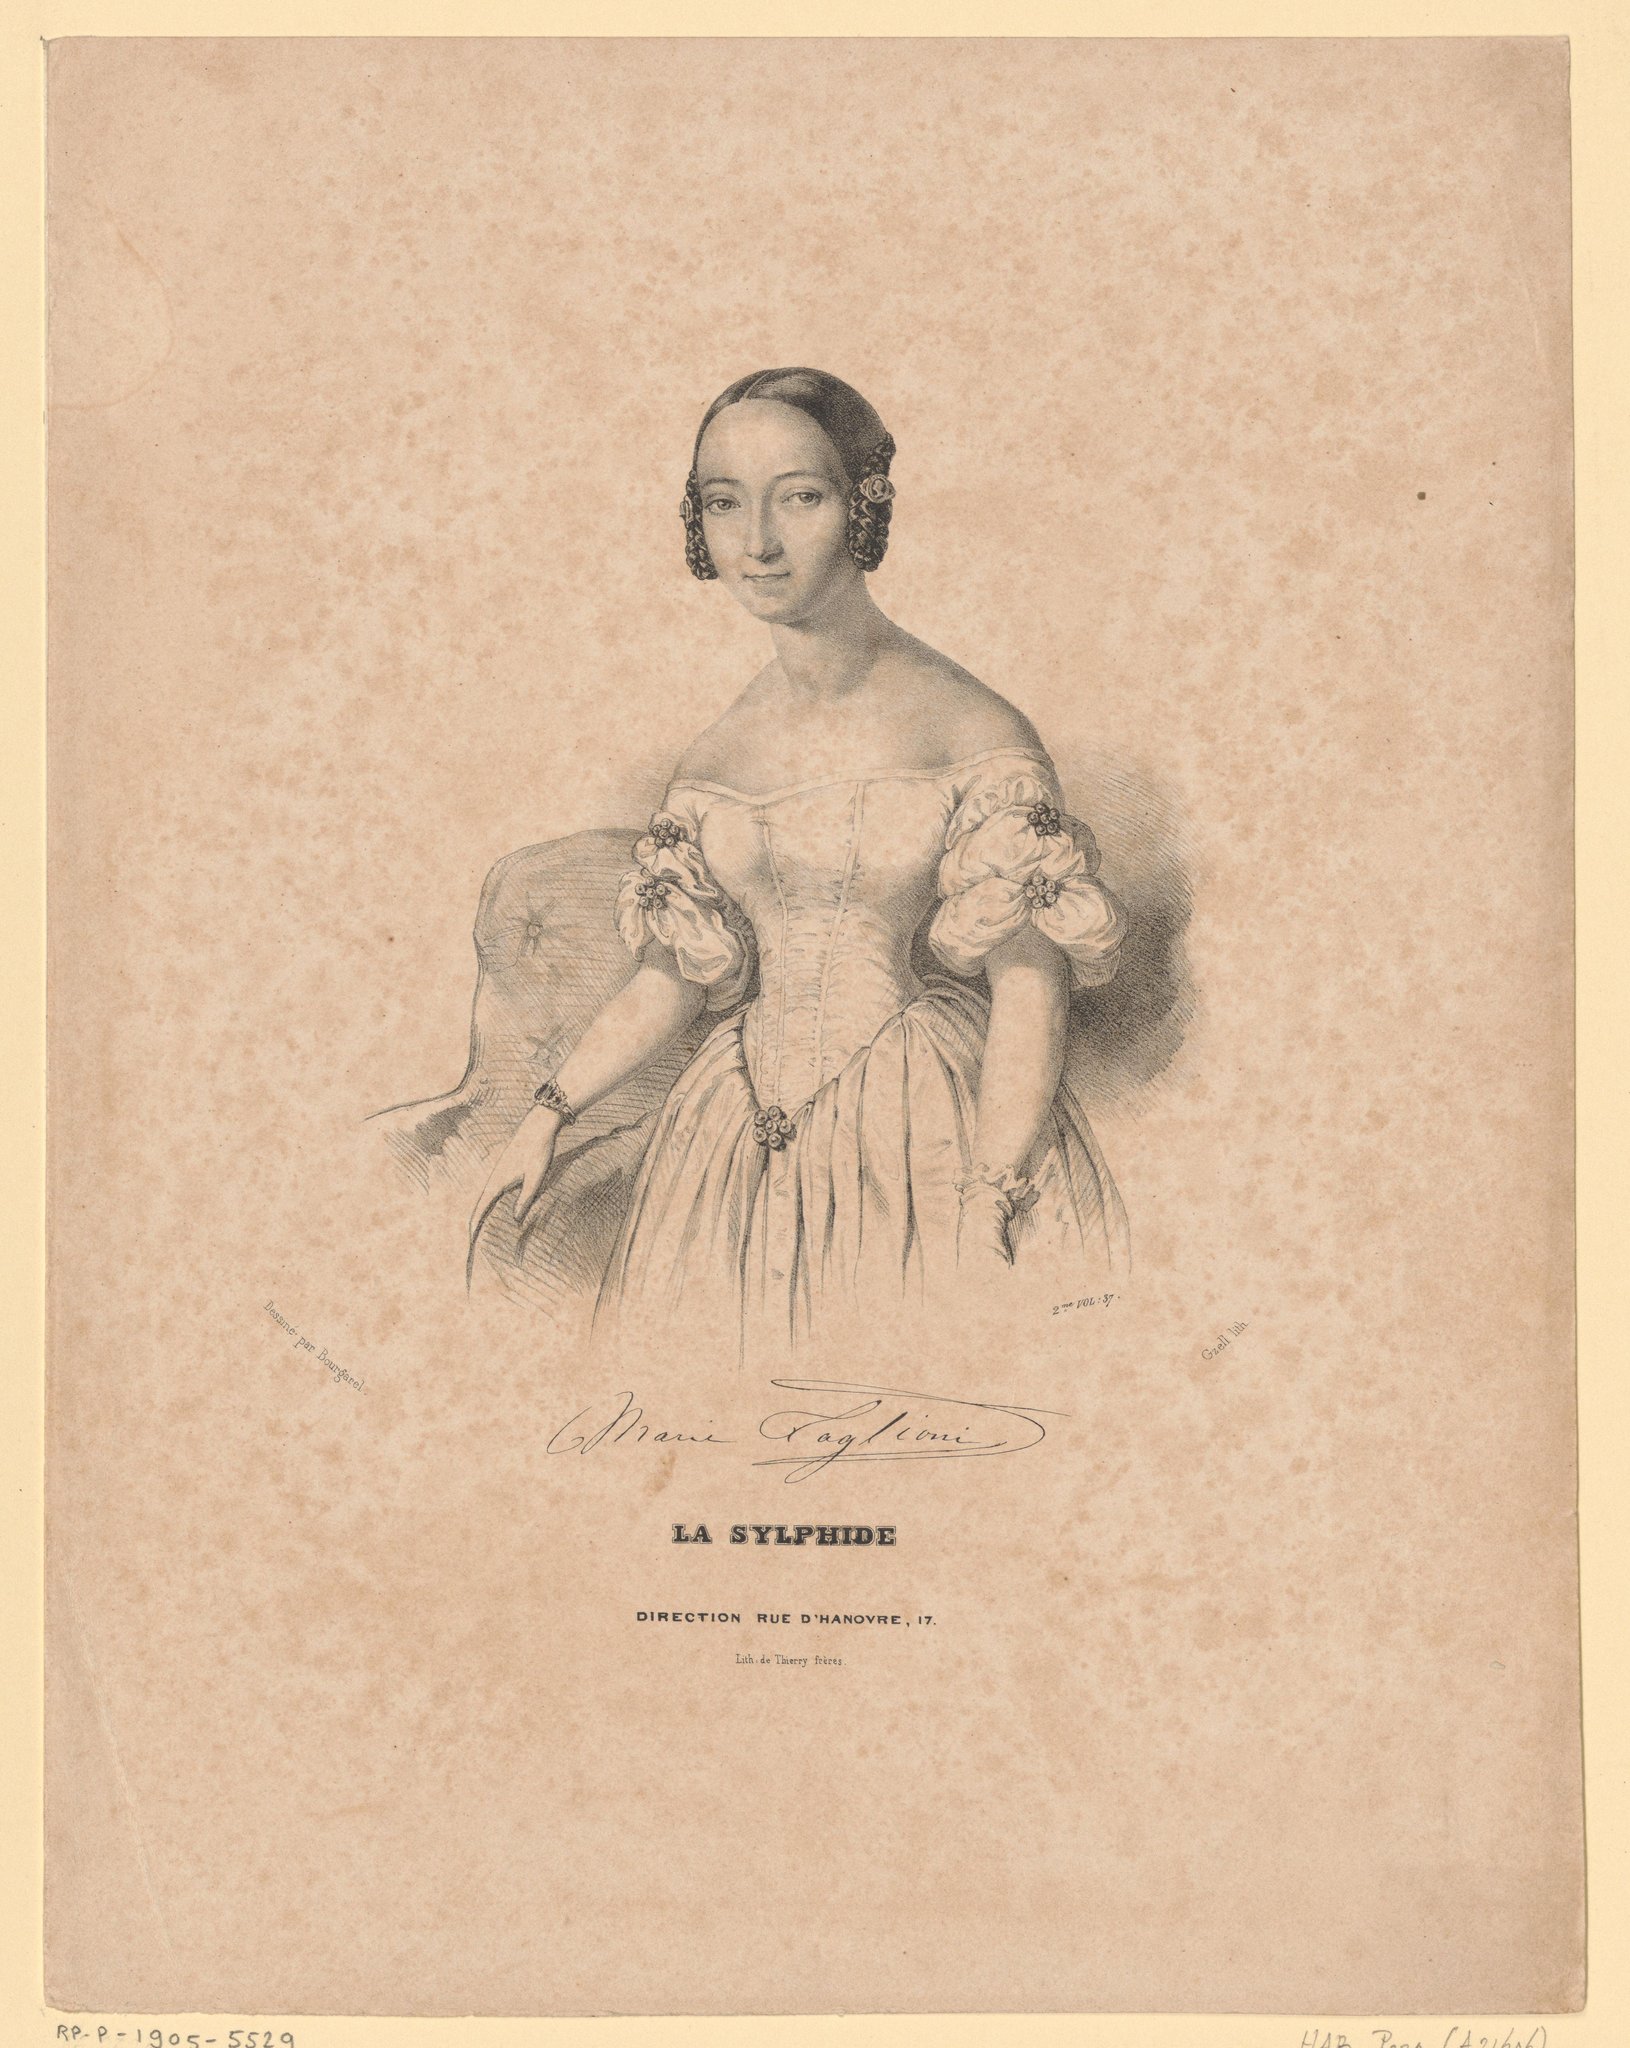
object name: print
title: Portret van Marie Taglioni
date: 1833-1870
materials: paper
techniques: lithograph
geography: paris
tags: historical persons - bb - woman, female dancer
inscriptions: collector's mark: Lugt 2228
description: Afgebeeld in haar rol in het ballet La Sylphide. Rechtsonder het portret genummerd: 2me Vol: 37.